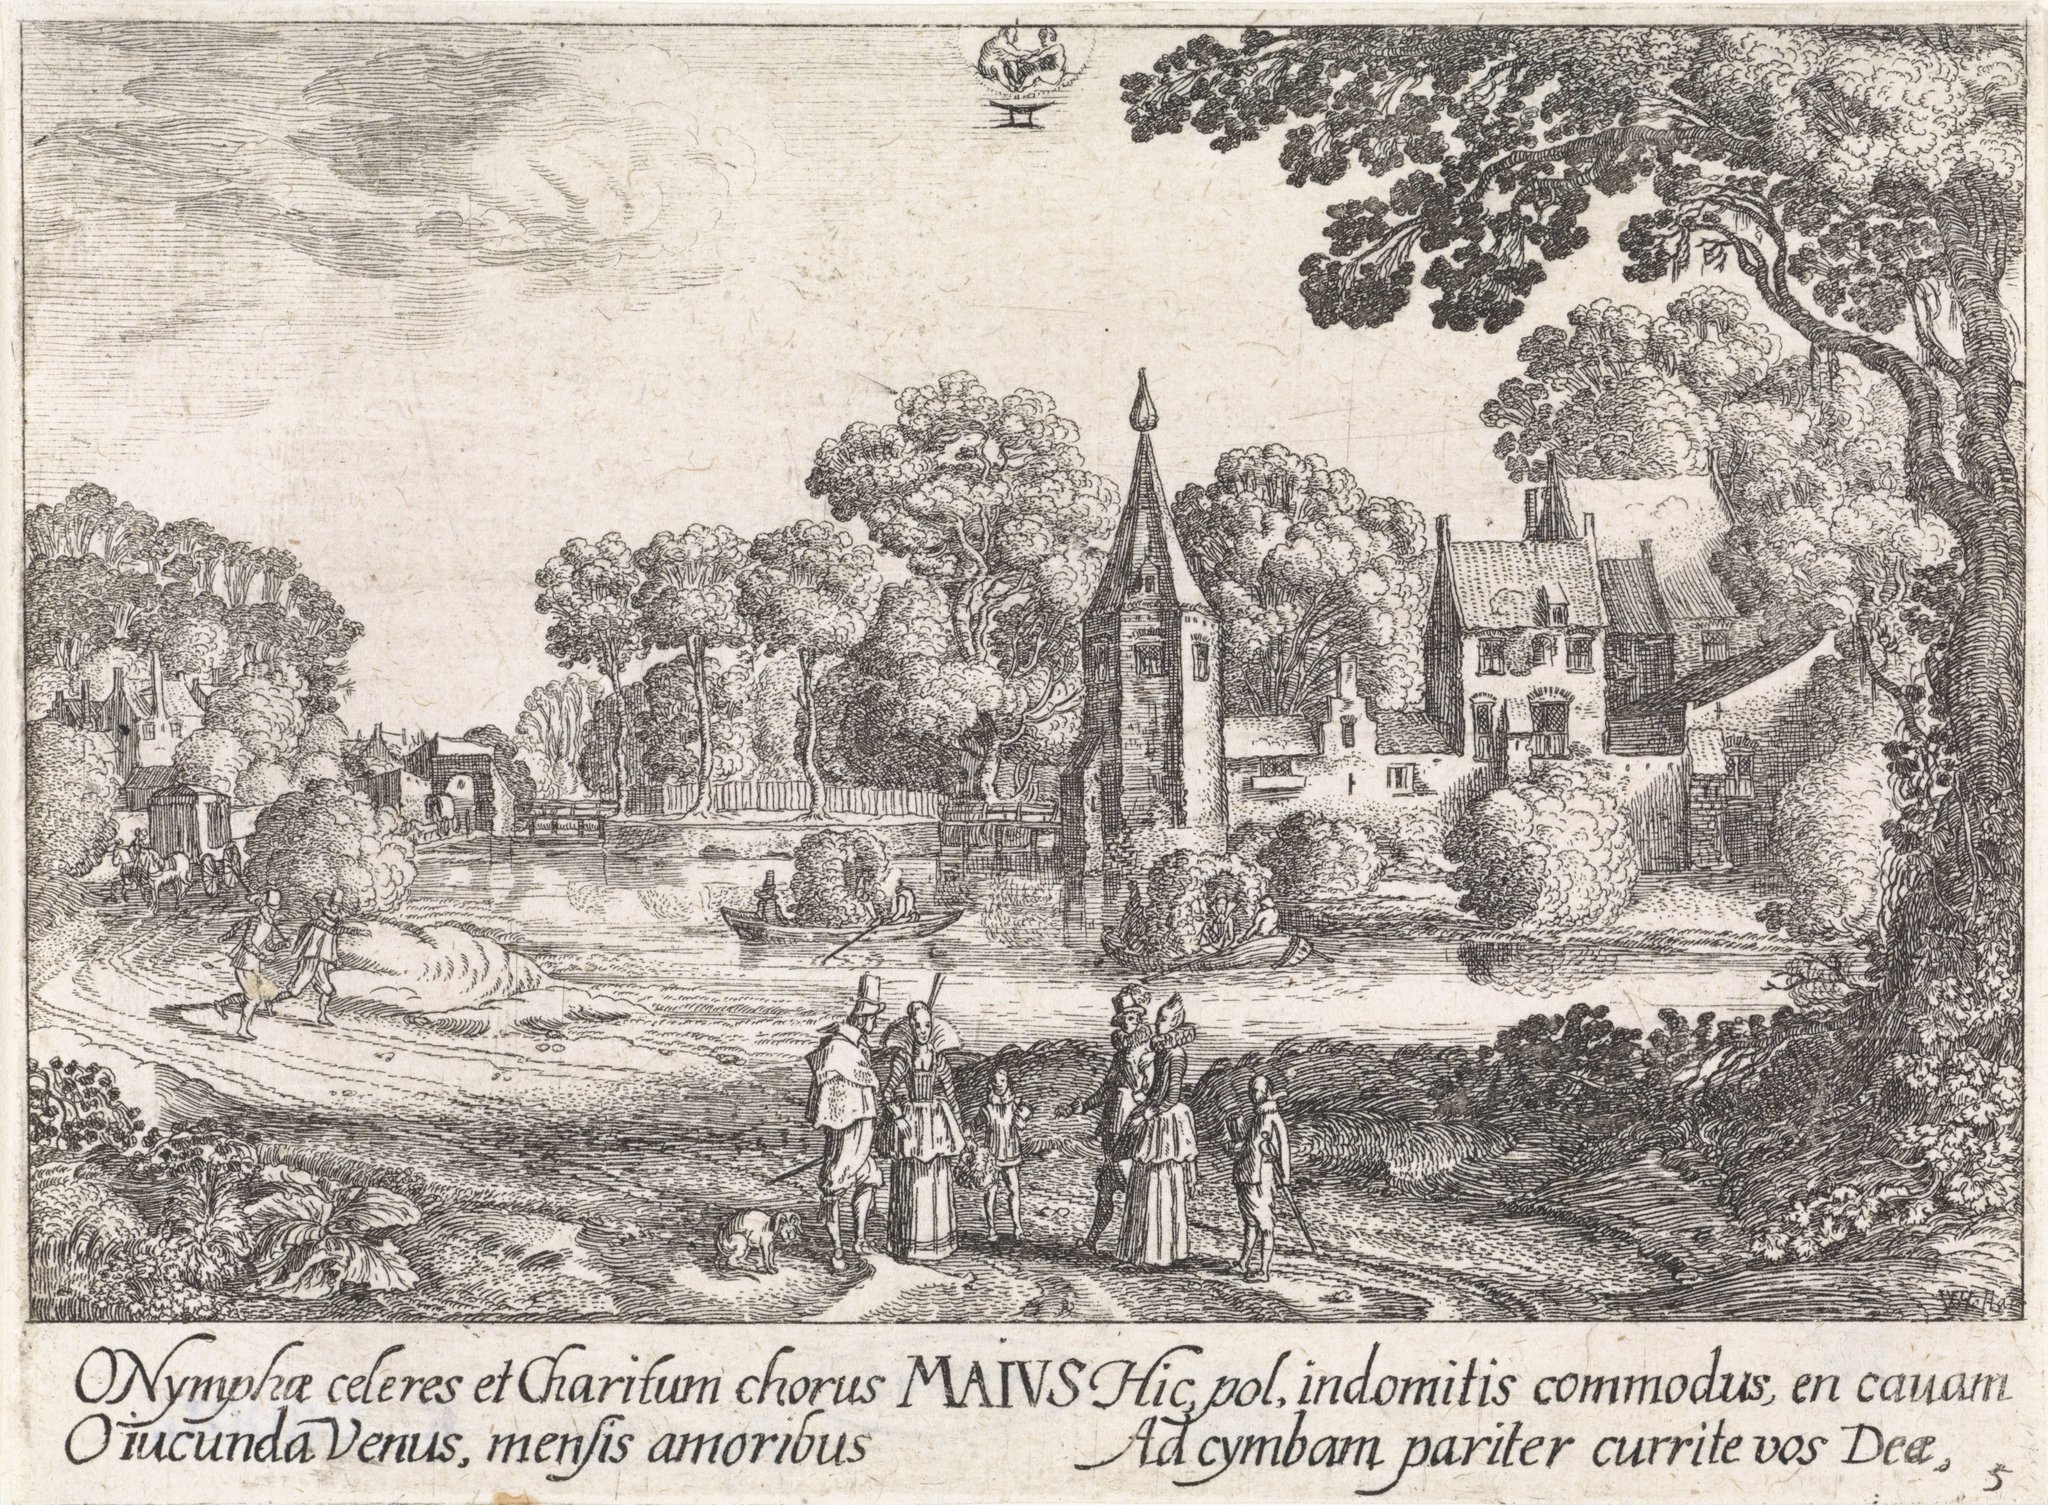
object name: print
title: Mei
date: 1684-1729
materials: paper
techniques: etching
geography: germany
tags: landscape symbolizing may, castle, may and its 'labours', open-air recreation, gemini (zodiacal sign of may), rowing, canoeing, etc. (sport)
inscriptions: collector's mark: Lugt 2760, collector's mark: Lugt 3790, collector's mark: Lugt 384, collector's mark: Lugt 2228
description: Landschap met een elegant gezelschap op een landweg voor een versterkt huis bij een meer; de Beervout Hostede bij Leiden, voorstellende de maand mei. Bovenaan het bij deze maand behorende sterrenbeeld: tweelingen. Vijfde prent uit een serie van twaalf.